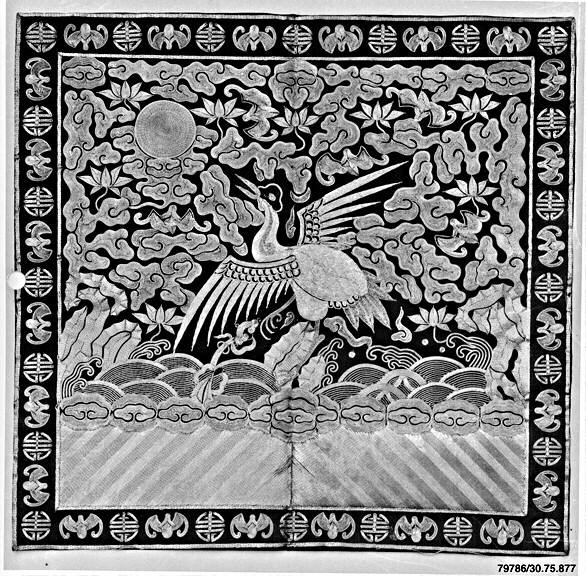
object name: rank badge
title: Rank Badge with Manchurian Crane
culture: chinese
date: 1801-1900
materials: metal thread, silk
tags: bats,cranes